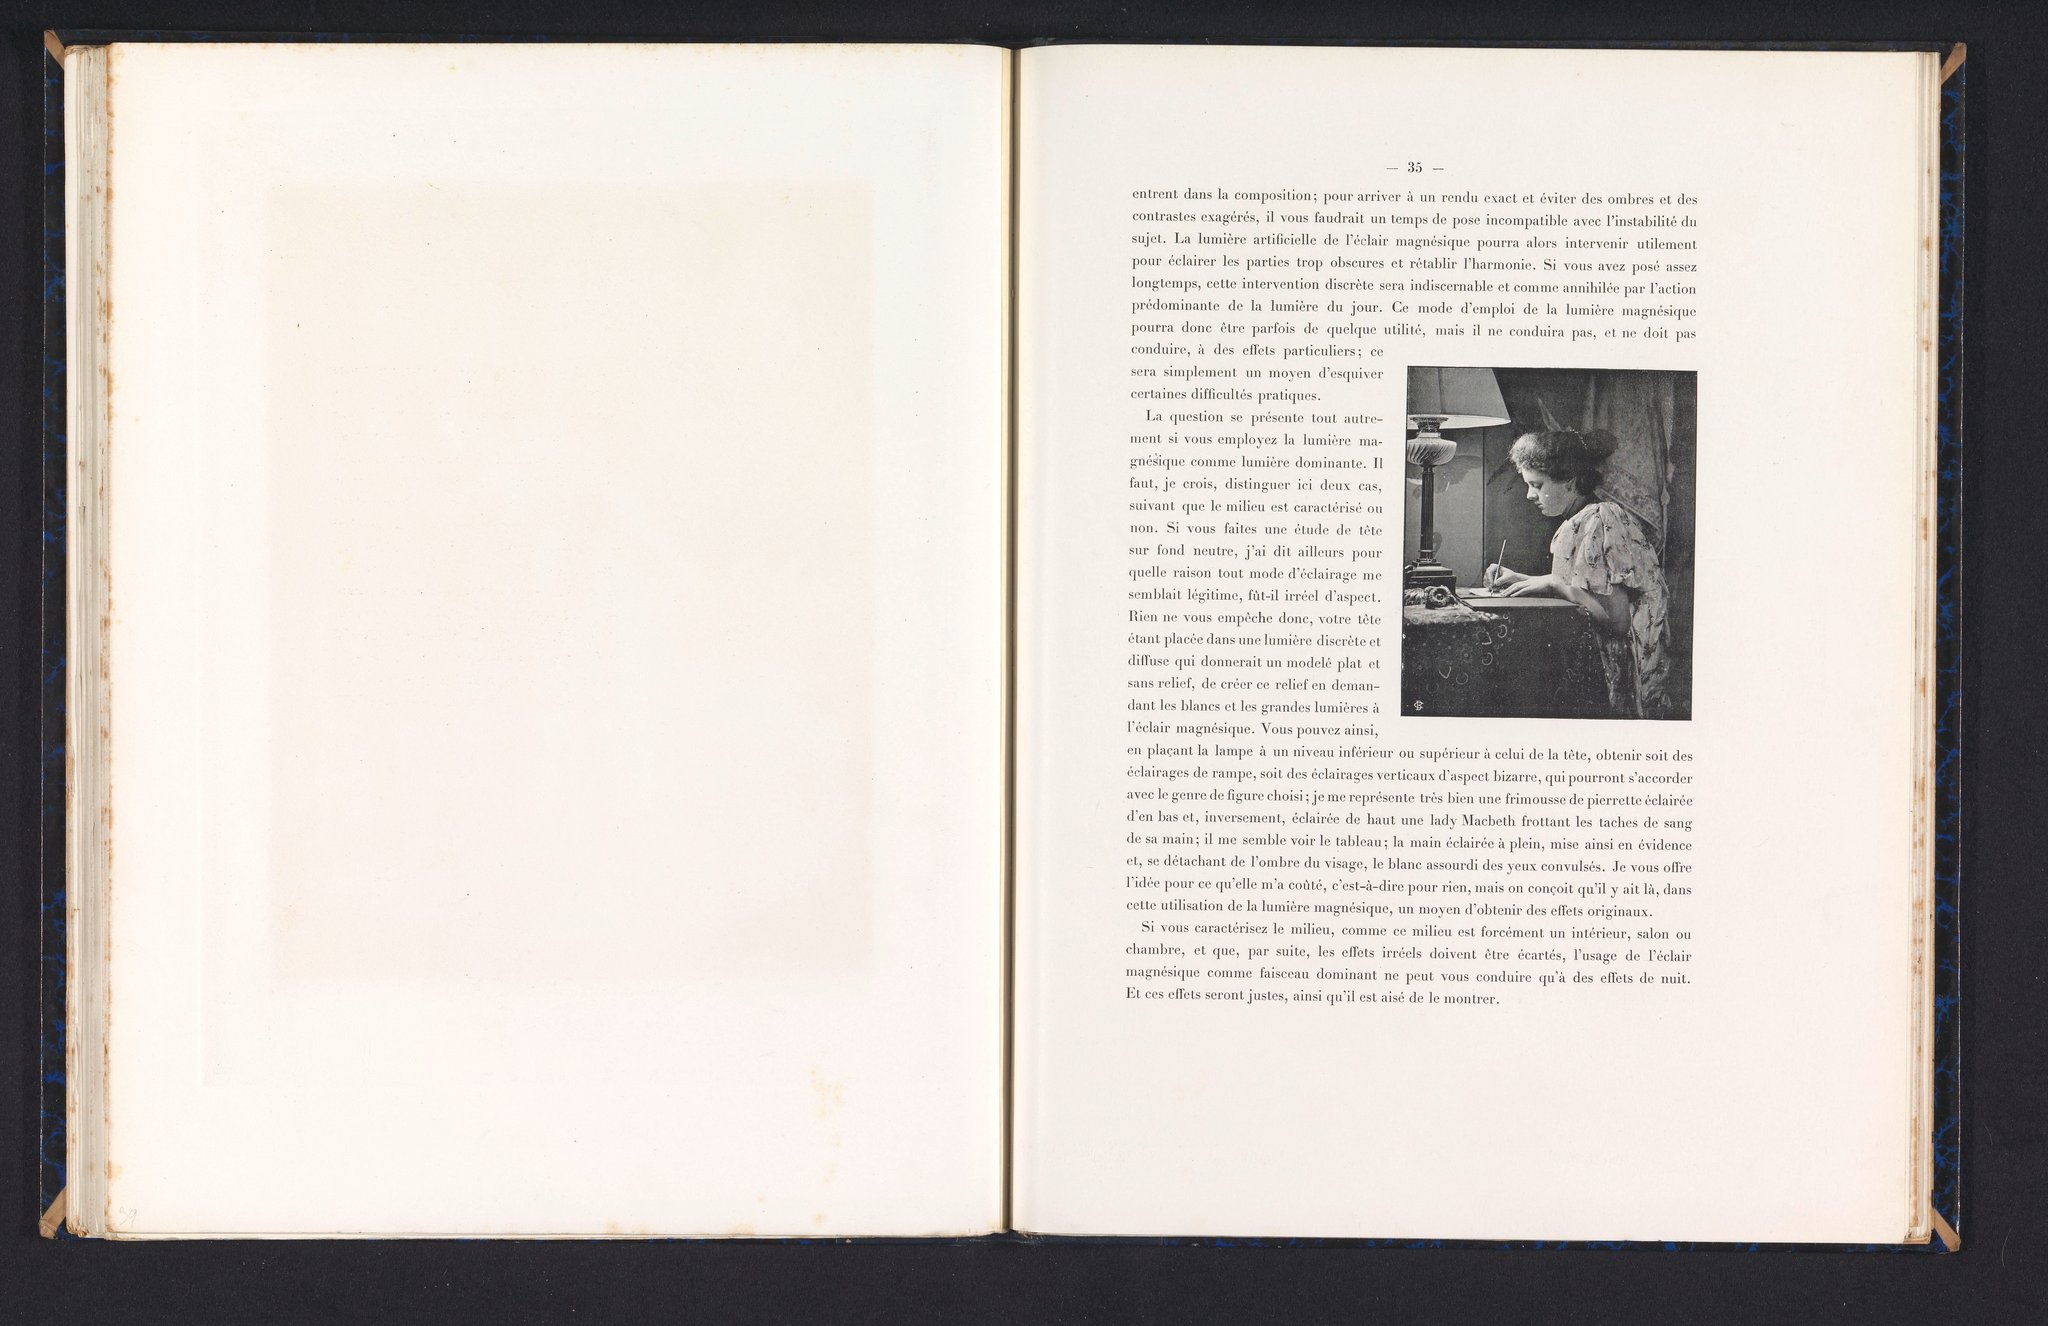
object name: photomechanical print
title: Schrijvende vrouw aan een tafel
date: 1886-1896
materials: paper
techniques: autotype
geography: france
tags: handwriting, writing as activity, adult woman, table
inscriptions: inscription: ‘CB’